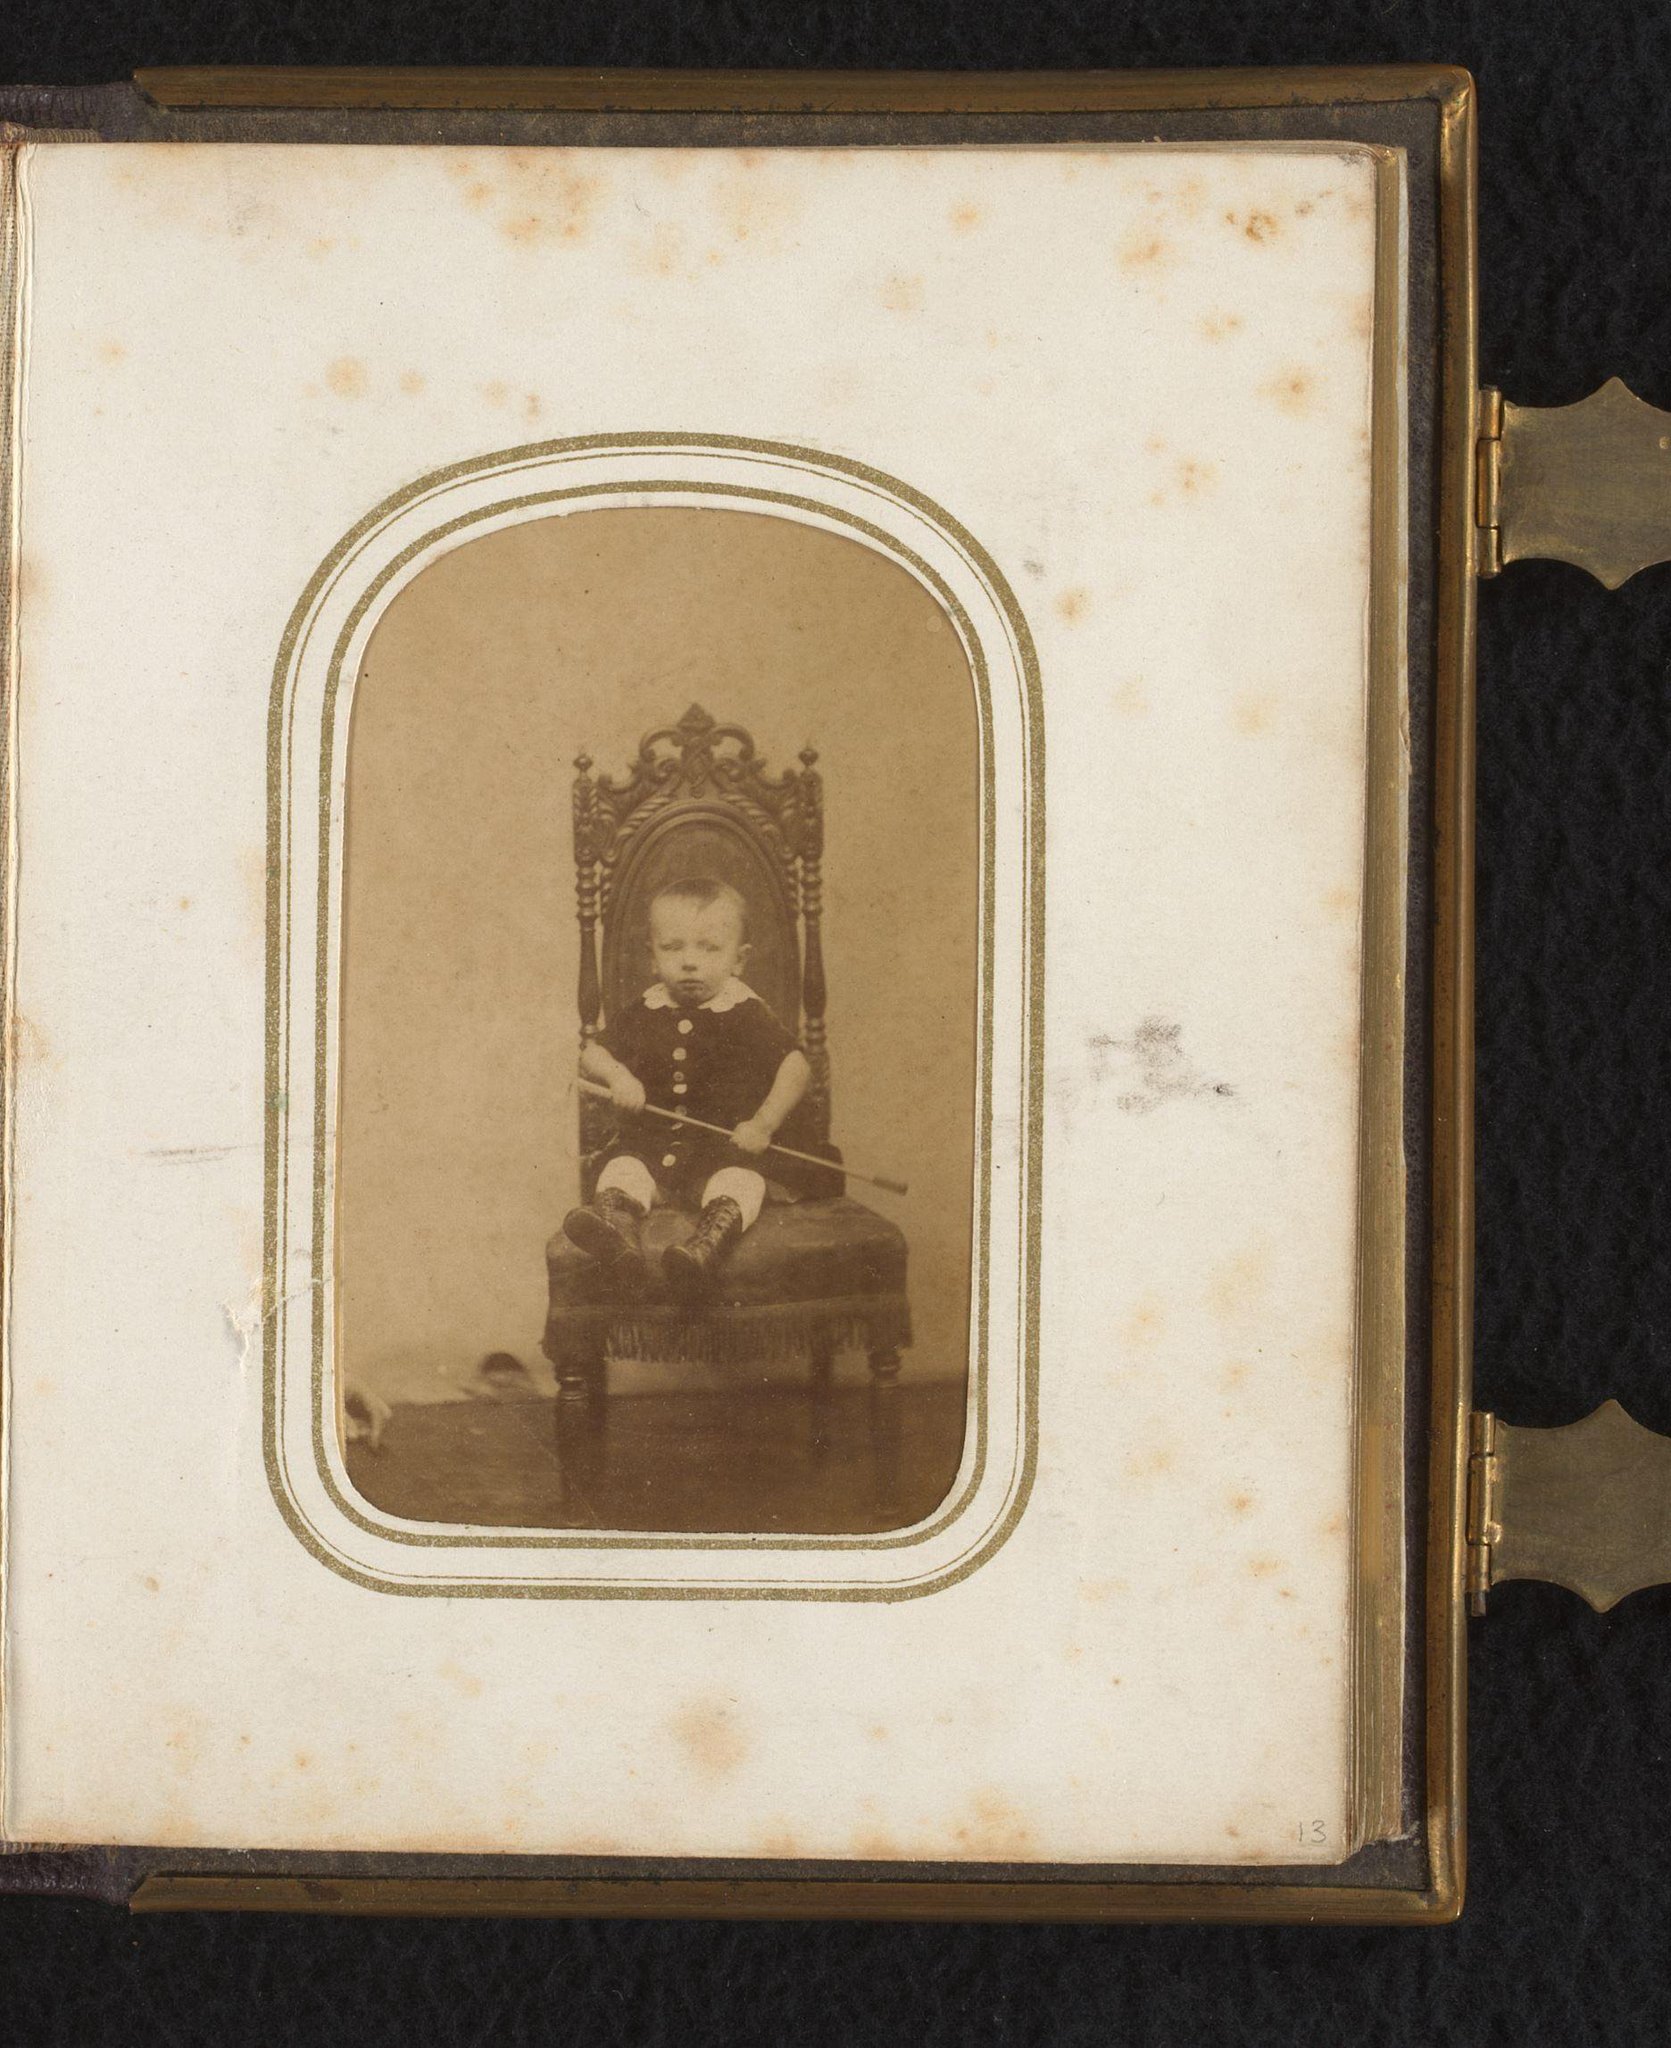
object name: photograph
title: Portret van een kind op een stoel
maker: willem herman andries kampfraath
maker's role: fotograaf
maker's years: 1839-1906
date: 1877-1884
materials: cardboard, photographic support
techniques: albumen print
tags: child, historical persons, chair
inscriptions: inscription: ‘W.H.A. Kampfraath/ Photograaf van Z.M.d. Koning der Nederlanden/ Egelantiersgracht 91/ Amsterdam’